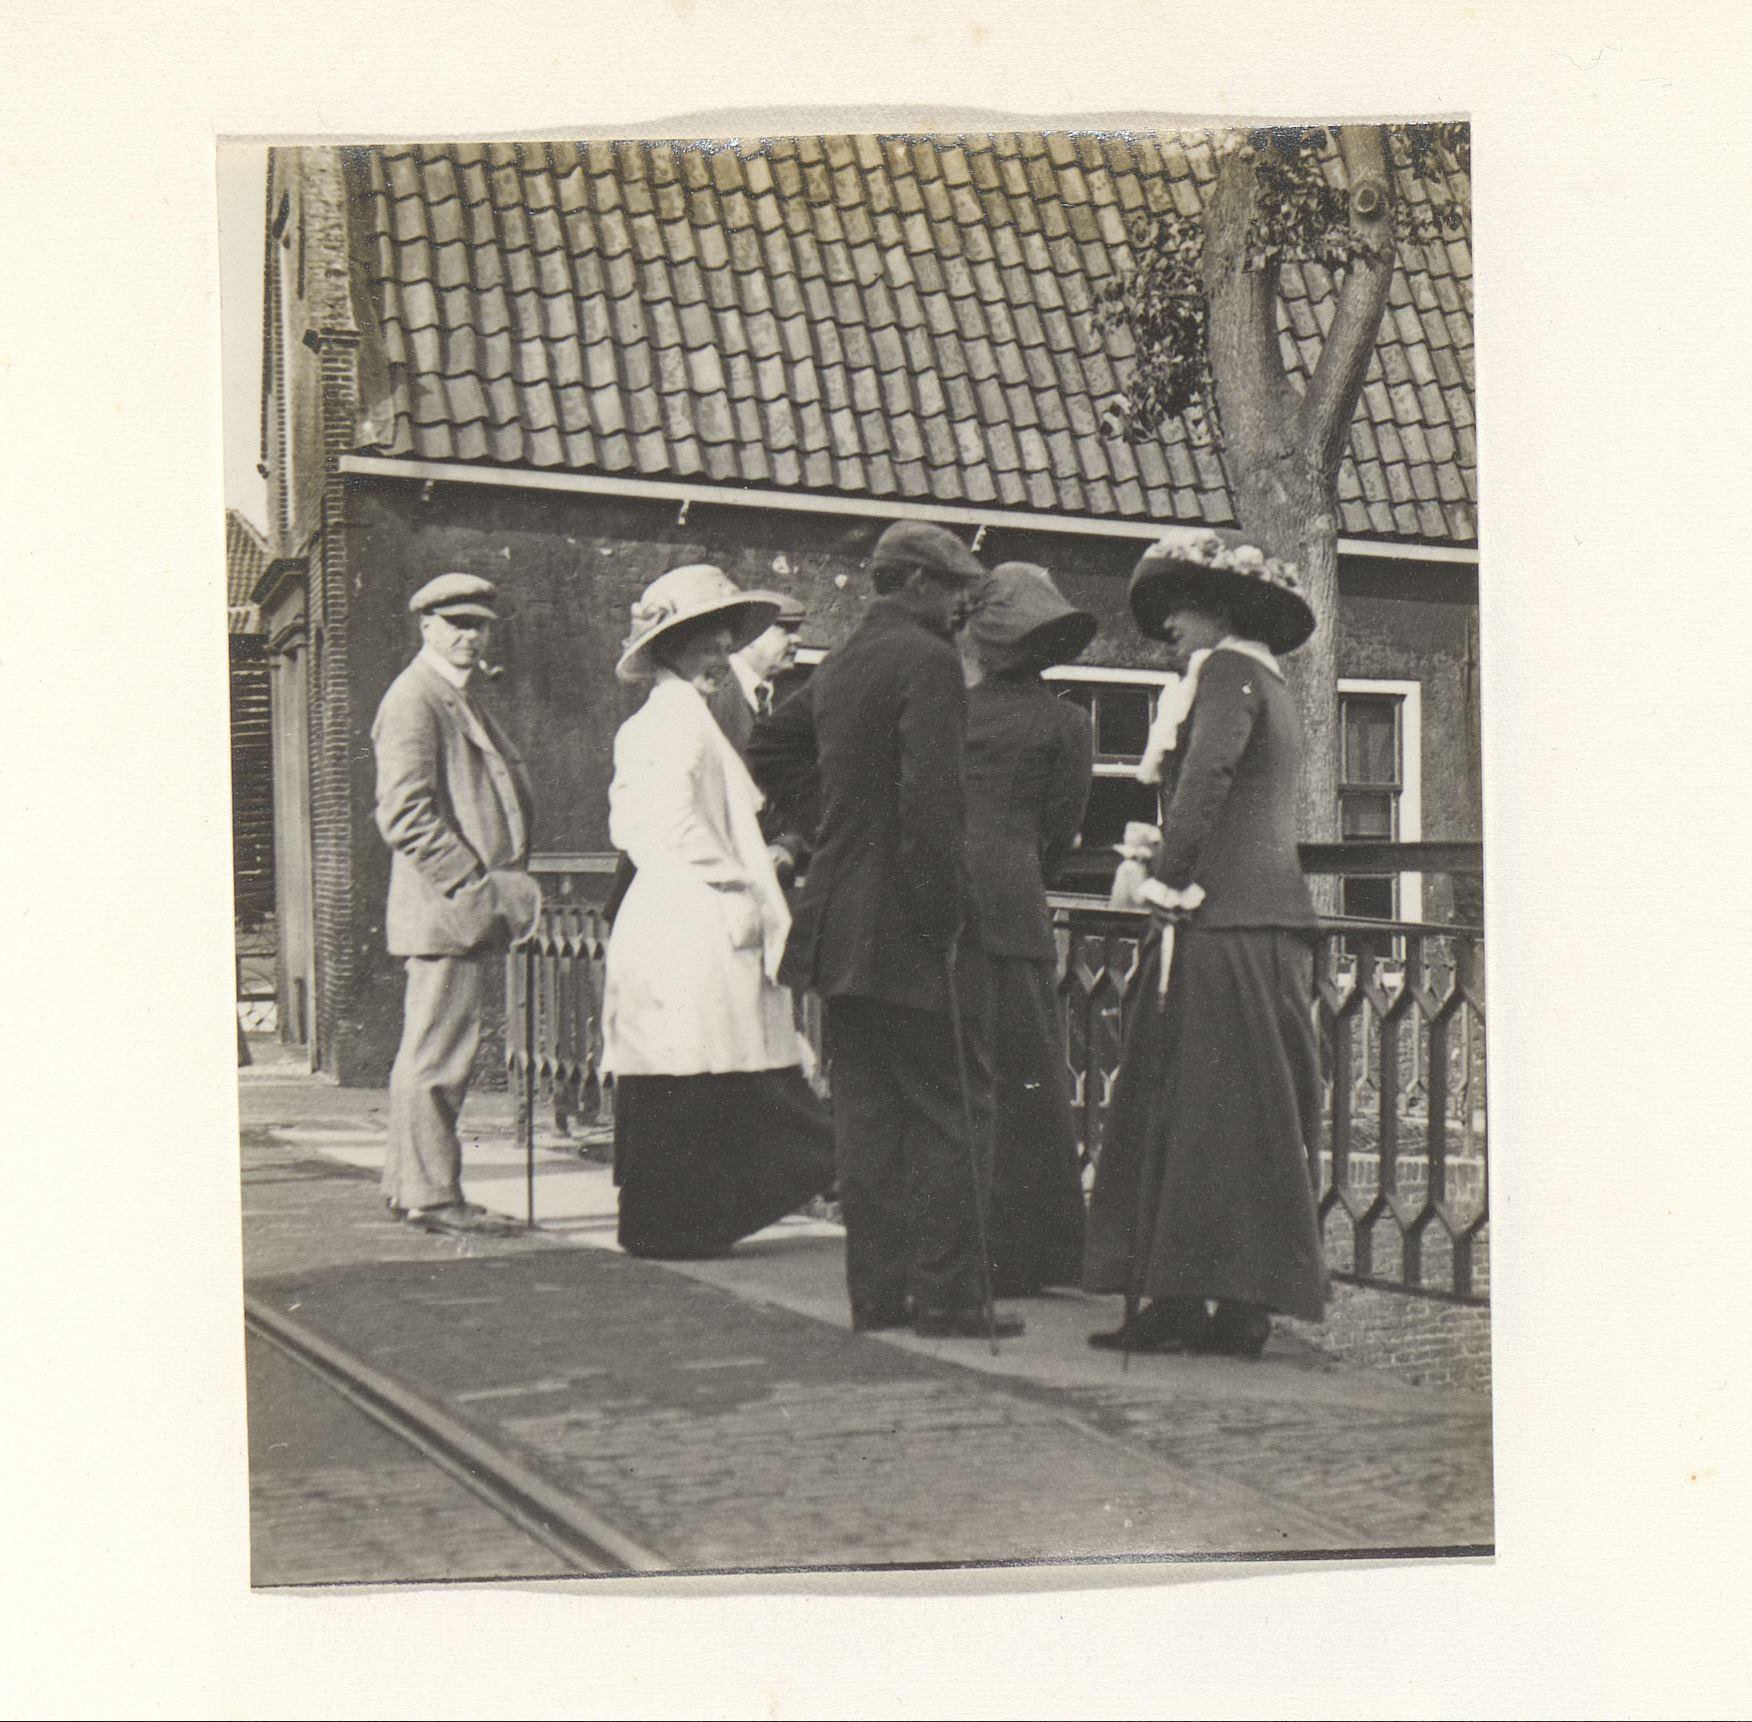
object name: photograph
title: Mannen en vrouwen op straat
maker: george hidderley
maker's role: fotograaf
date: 1900-1910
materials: paper, photographic support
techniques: gelatin silver print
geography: volendam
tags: adult woman, adult man, historical persons, street